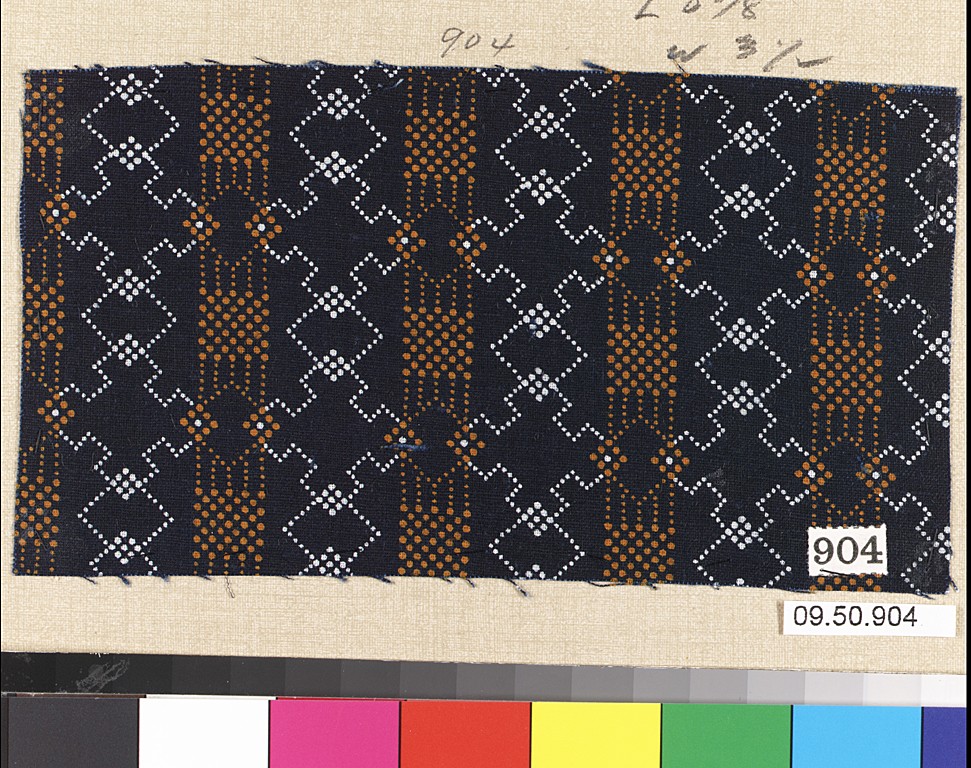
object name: piece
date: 1801-1900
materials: cotton